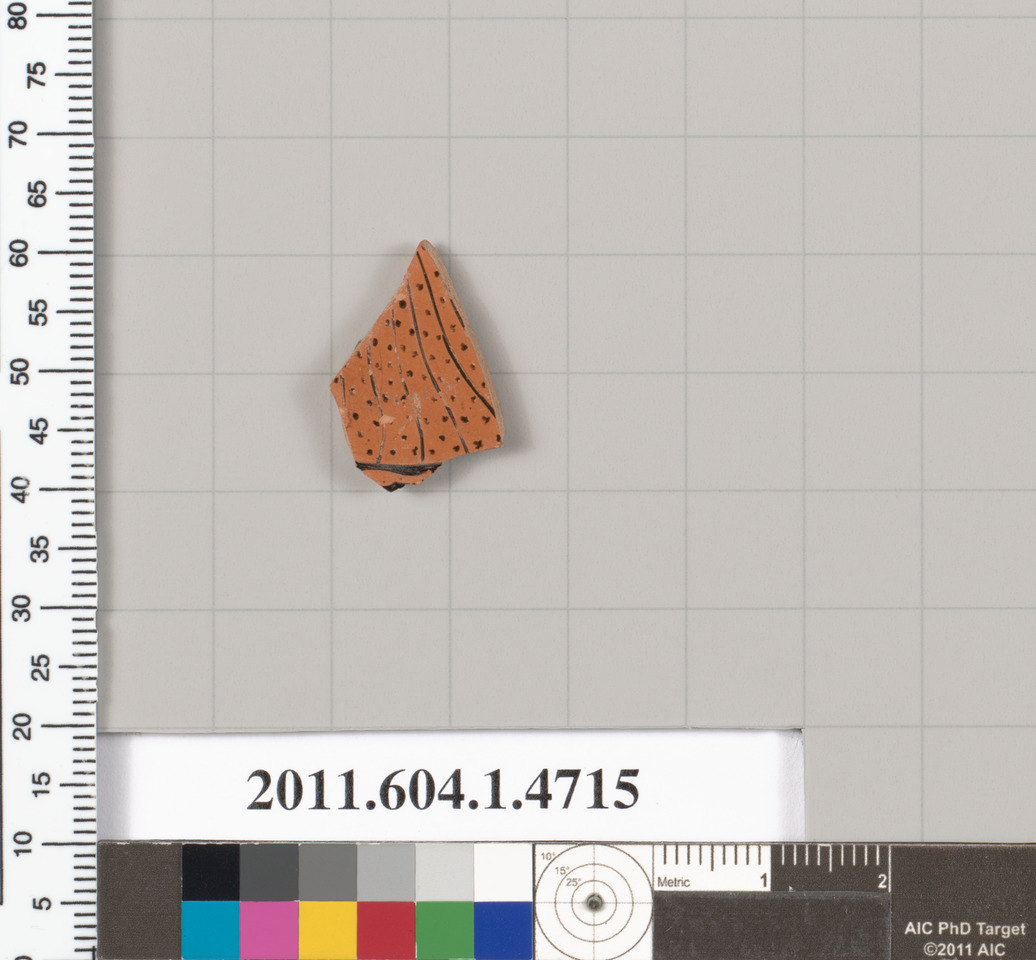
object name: kylix fragment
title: Terracotta fragment of a kylix (drinking cup)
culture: greek, attic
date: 490-480 BCE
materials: terracotta